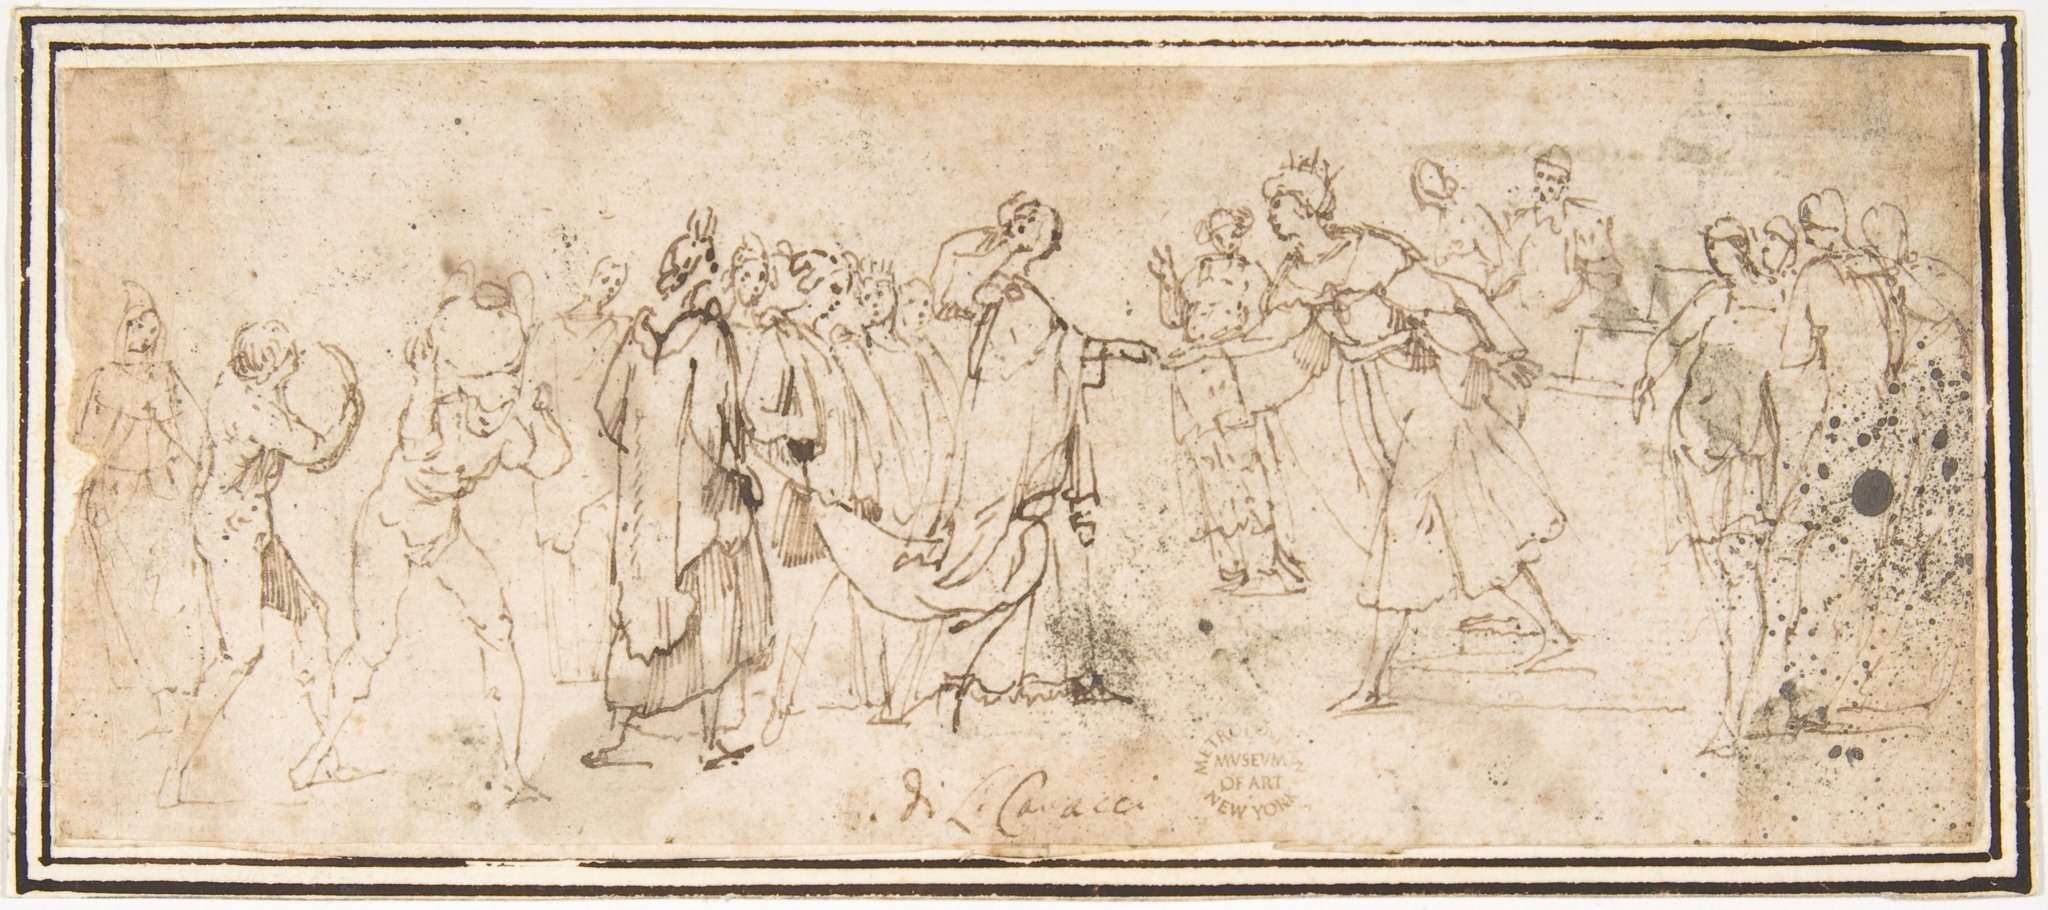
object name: drawing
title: King Solomon Receiving the Queen of Sheba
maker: francesco allegrini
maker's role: artist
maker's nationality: italian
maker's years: 1615-1679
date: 1624-1663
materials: ink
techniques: pen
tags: kings,queens,men,women